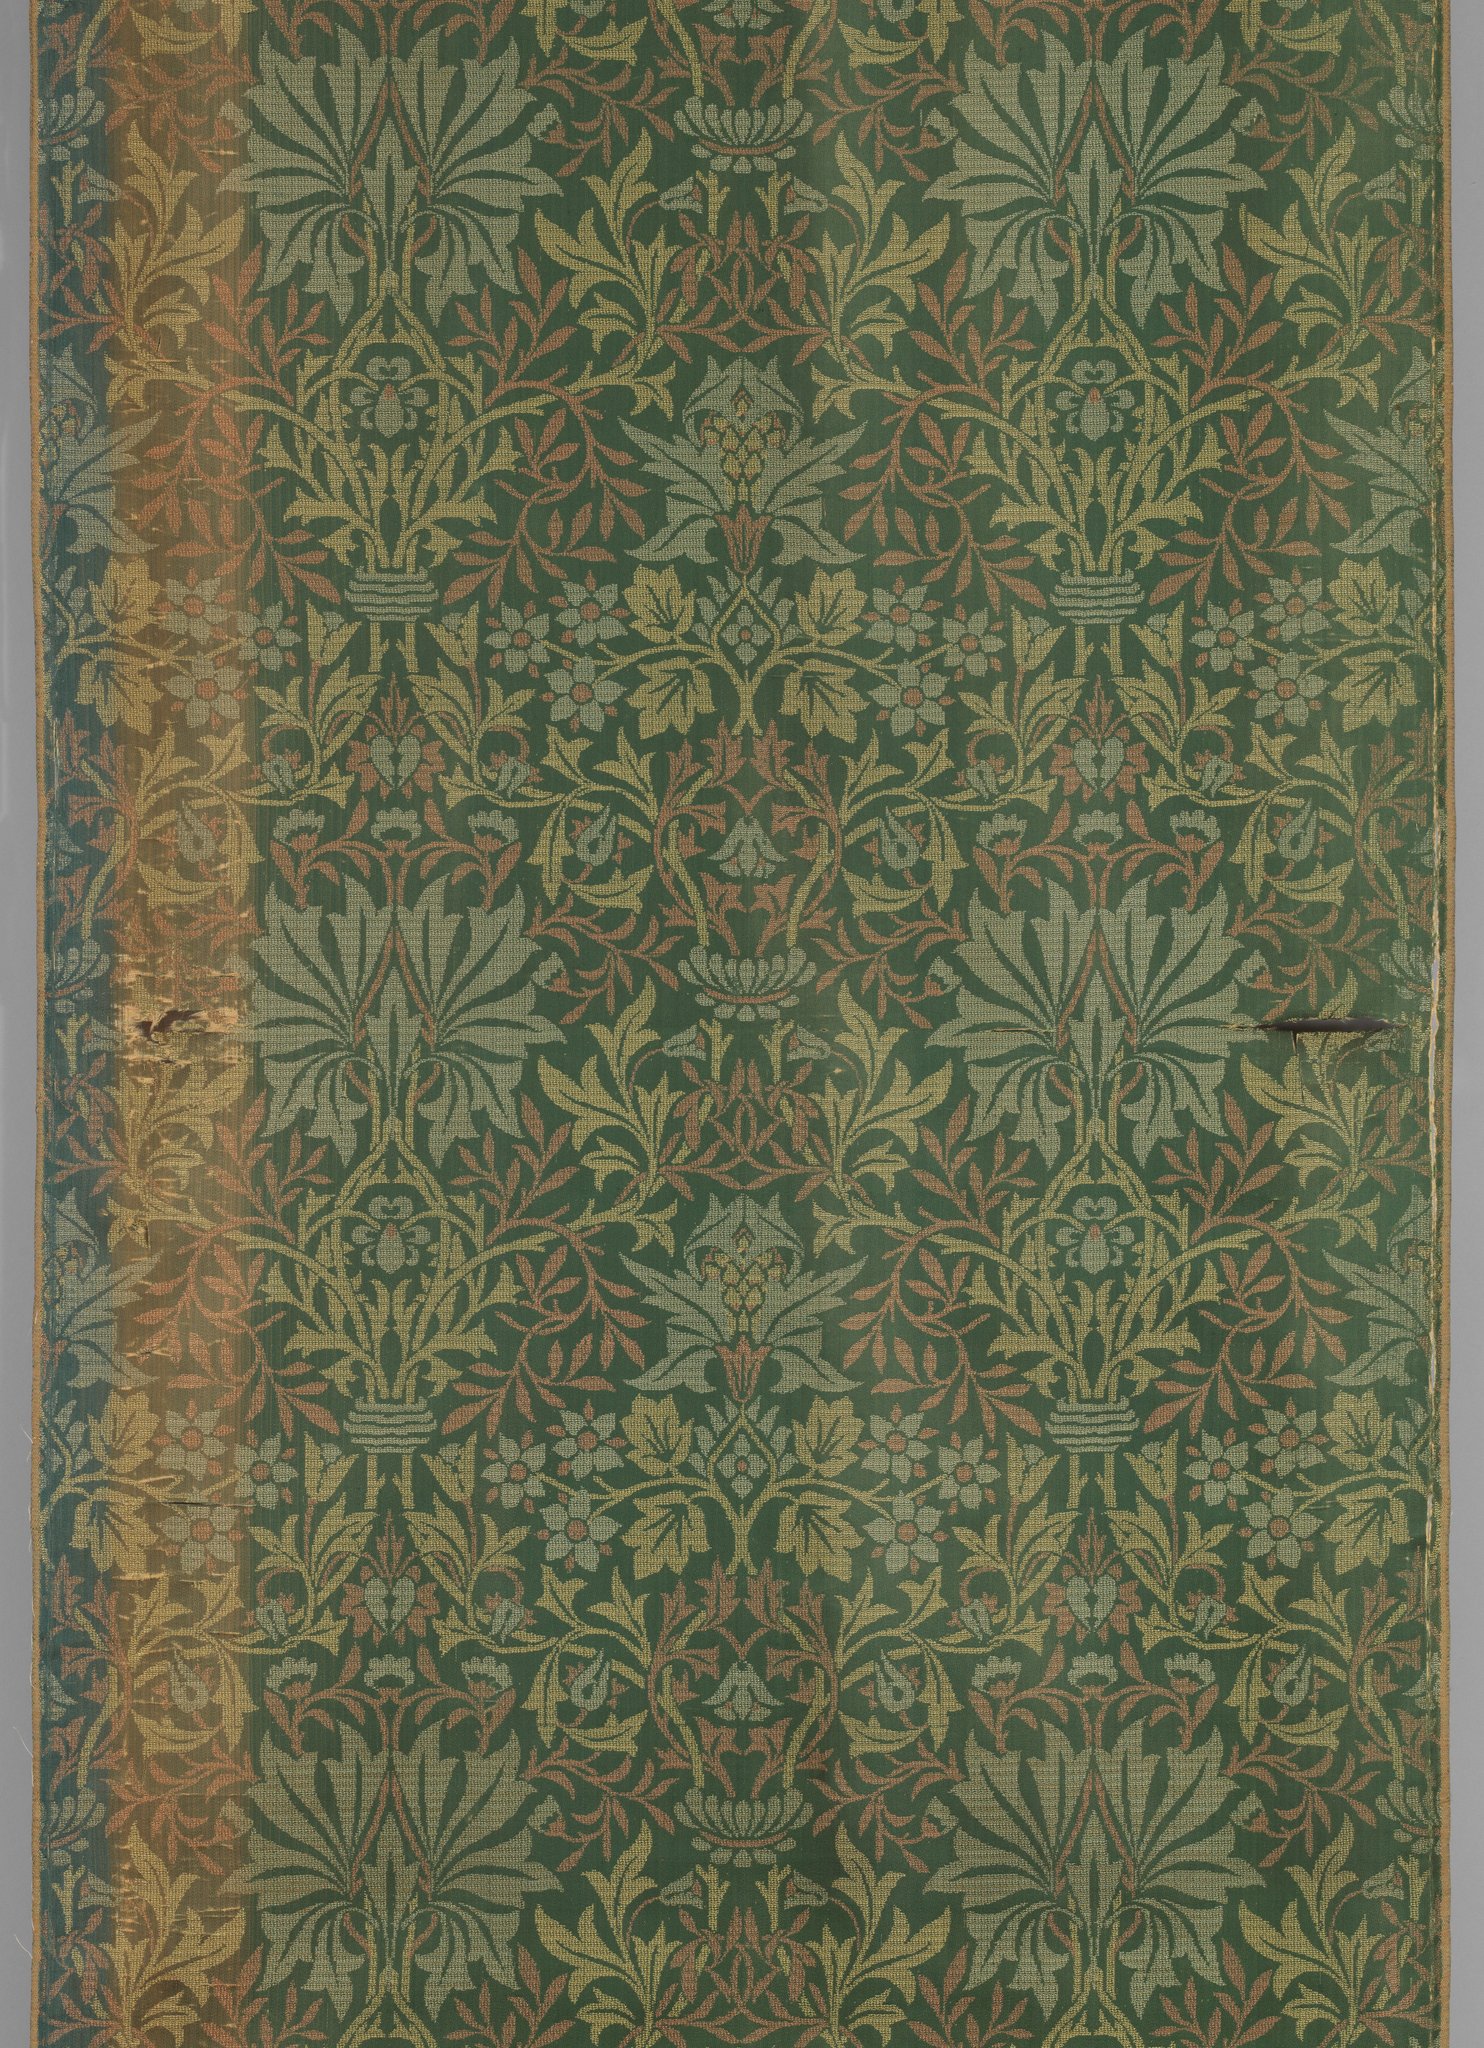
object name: sample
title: "Flower Garden"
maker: william morris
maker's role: designer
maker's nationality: british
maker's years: 1834-1896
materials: silk